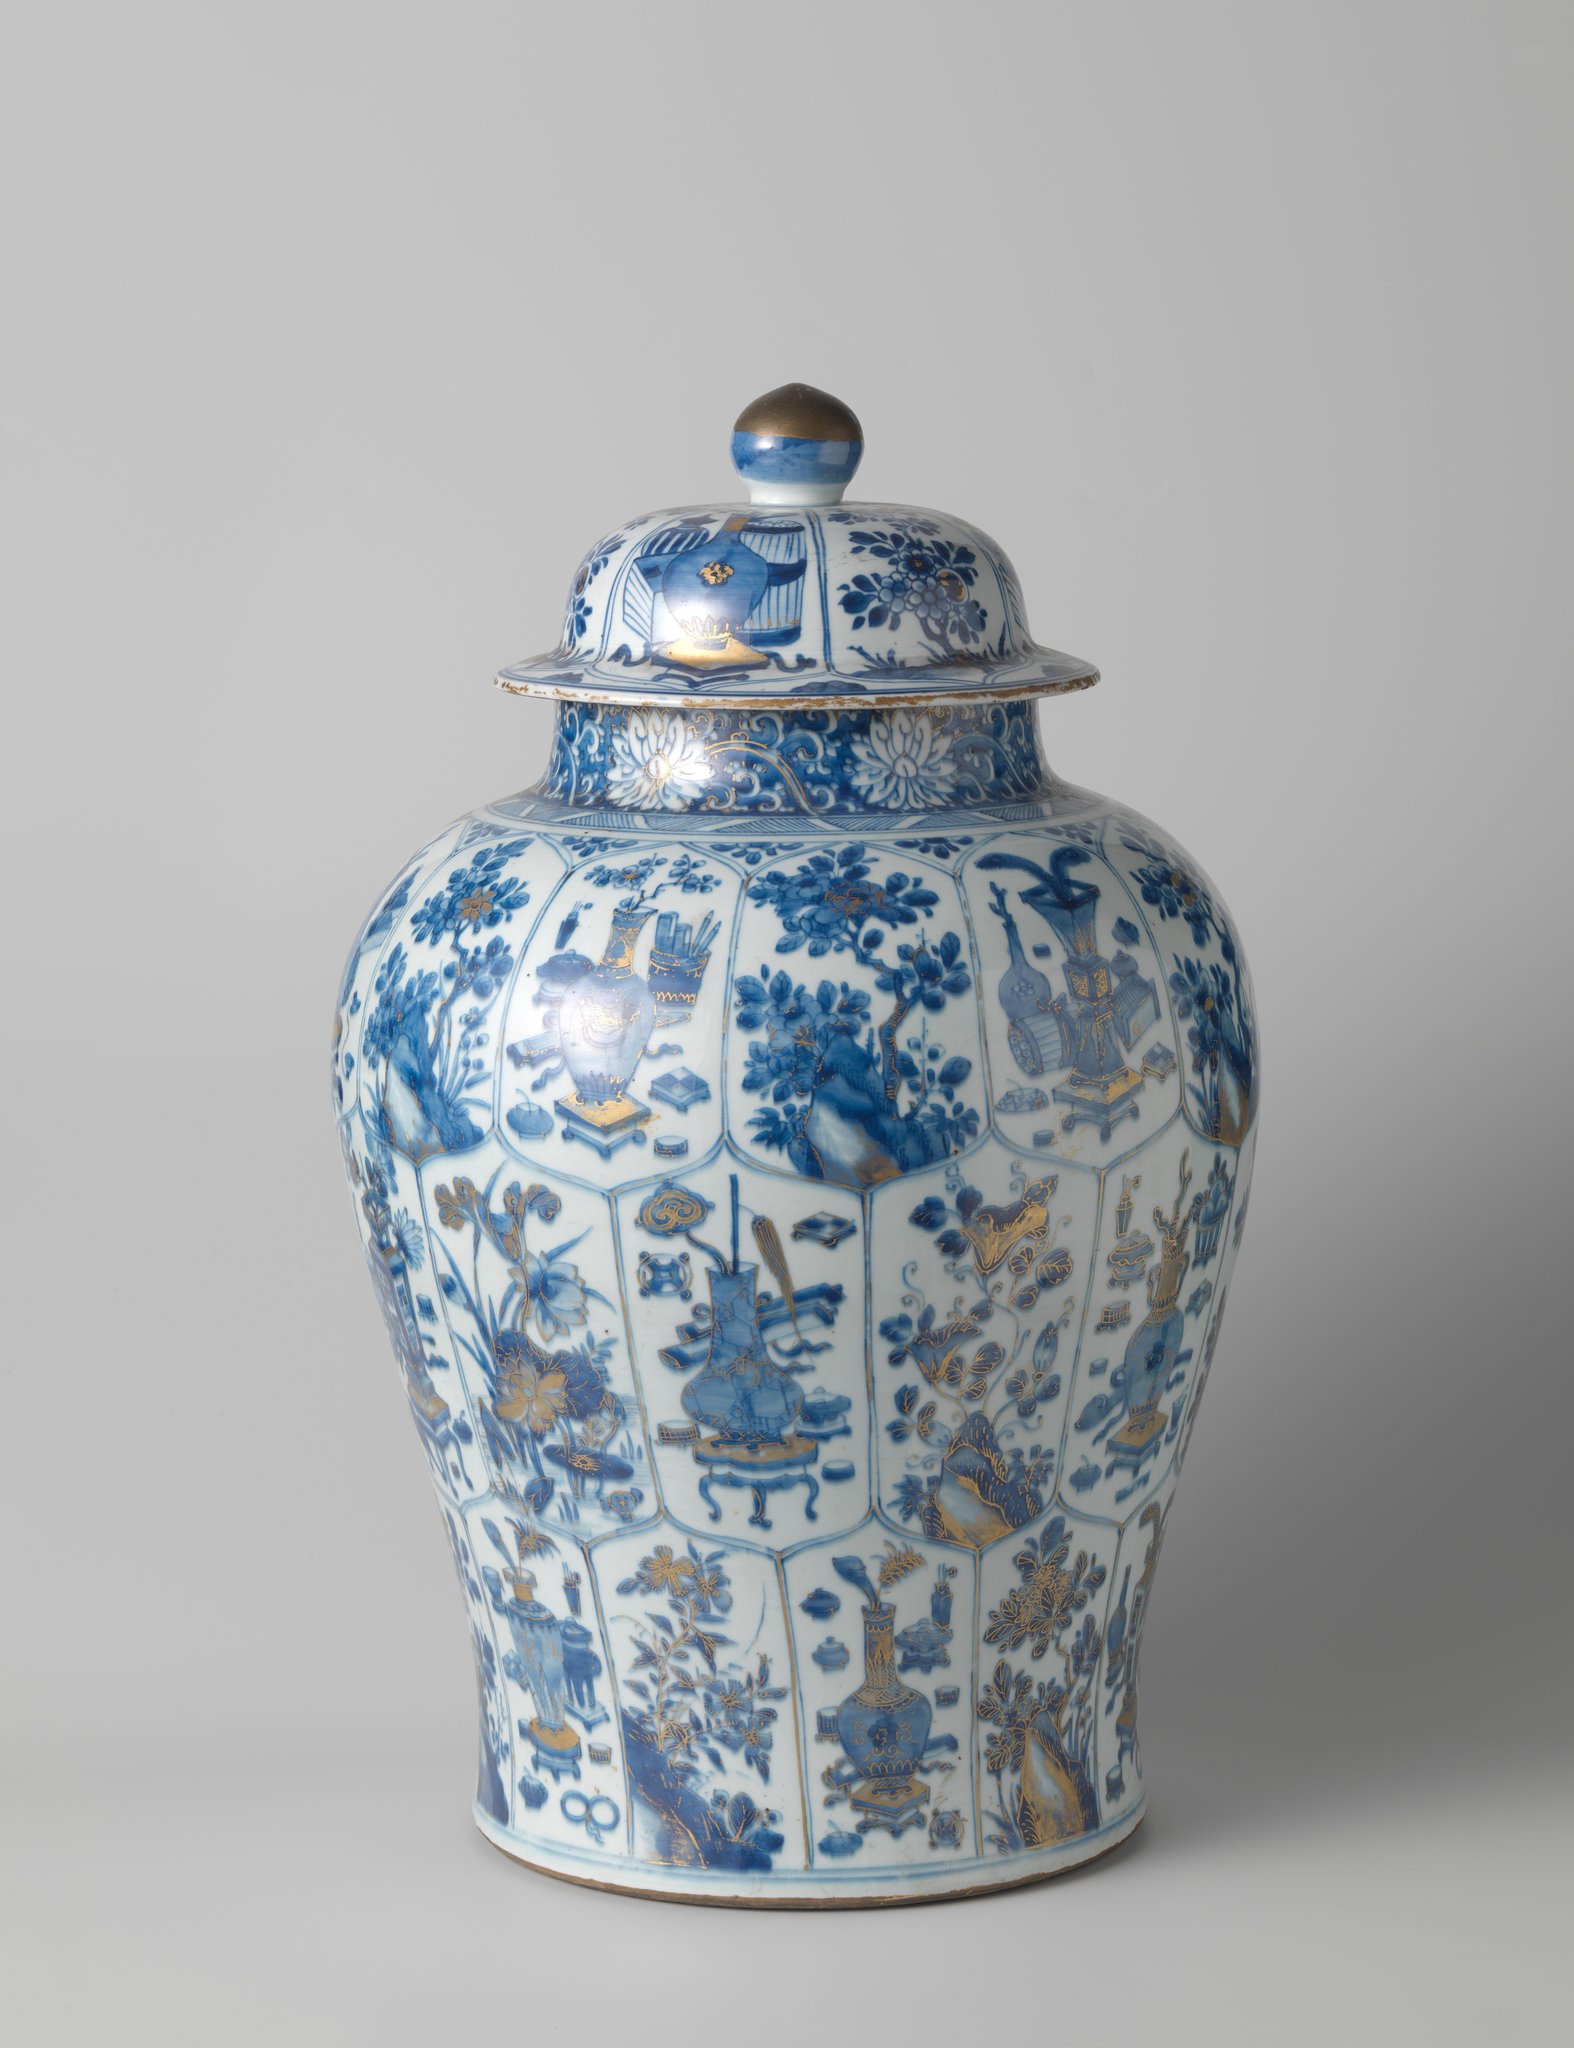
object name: pot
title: Baluster covered jar with flowering plants and auspicious symbols in panels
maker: Anonymous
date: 1680-1720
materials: cobalt, glaze, gold, paint, porcelain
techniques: firing, gilding, turning, vitrification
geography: china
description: Balustervormige dekselpot van porselein met een brede nek, beschilderd in onderglazuur blauw en op het glazuur goud. De wand is verdeeld in drie rijen met geschulpte, rechthoekige vakken met afwisselend een bloeiende plant bij een rots en gelukssymbolen en antiquiteiten. Op de nek een band met lotusranken uitgespaard in een blauwe achtergrond. De onderzijde is ongeglazuurd. Blauw-wit met goudemail.